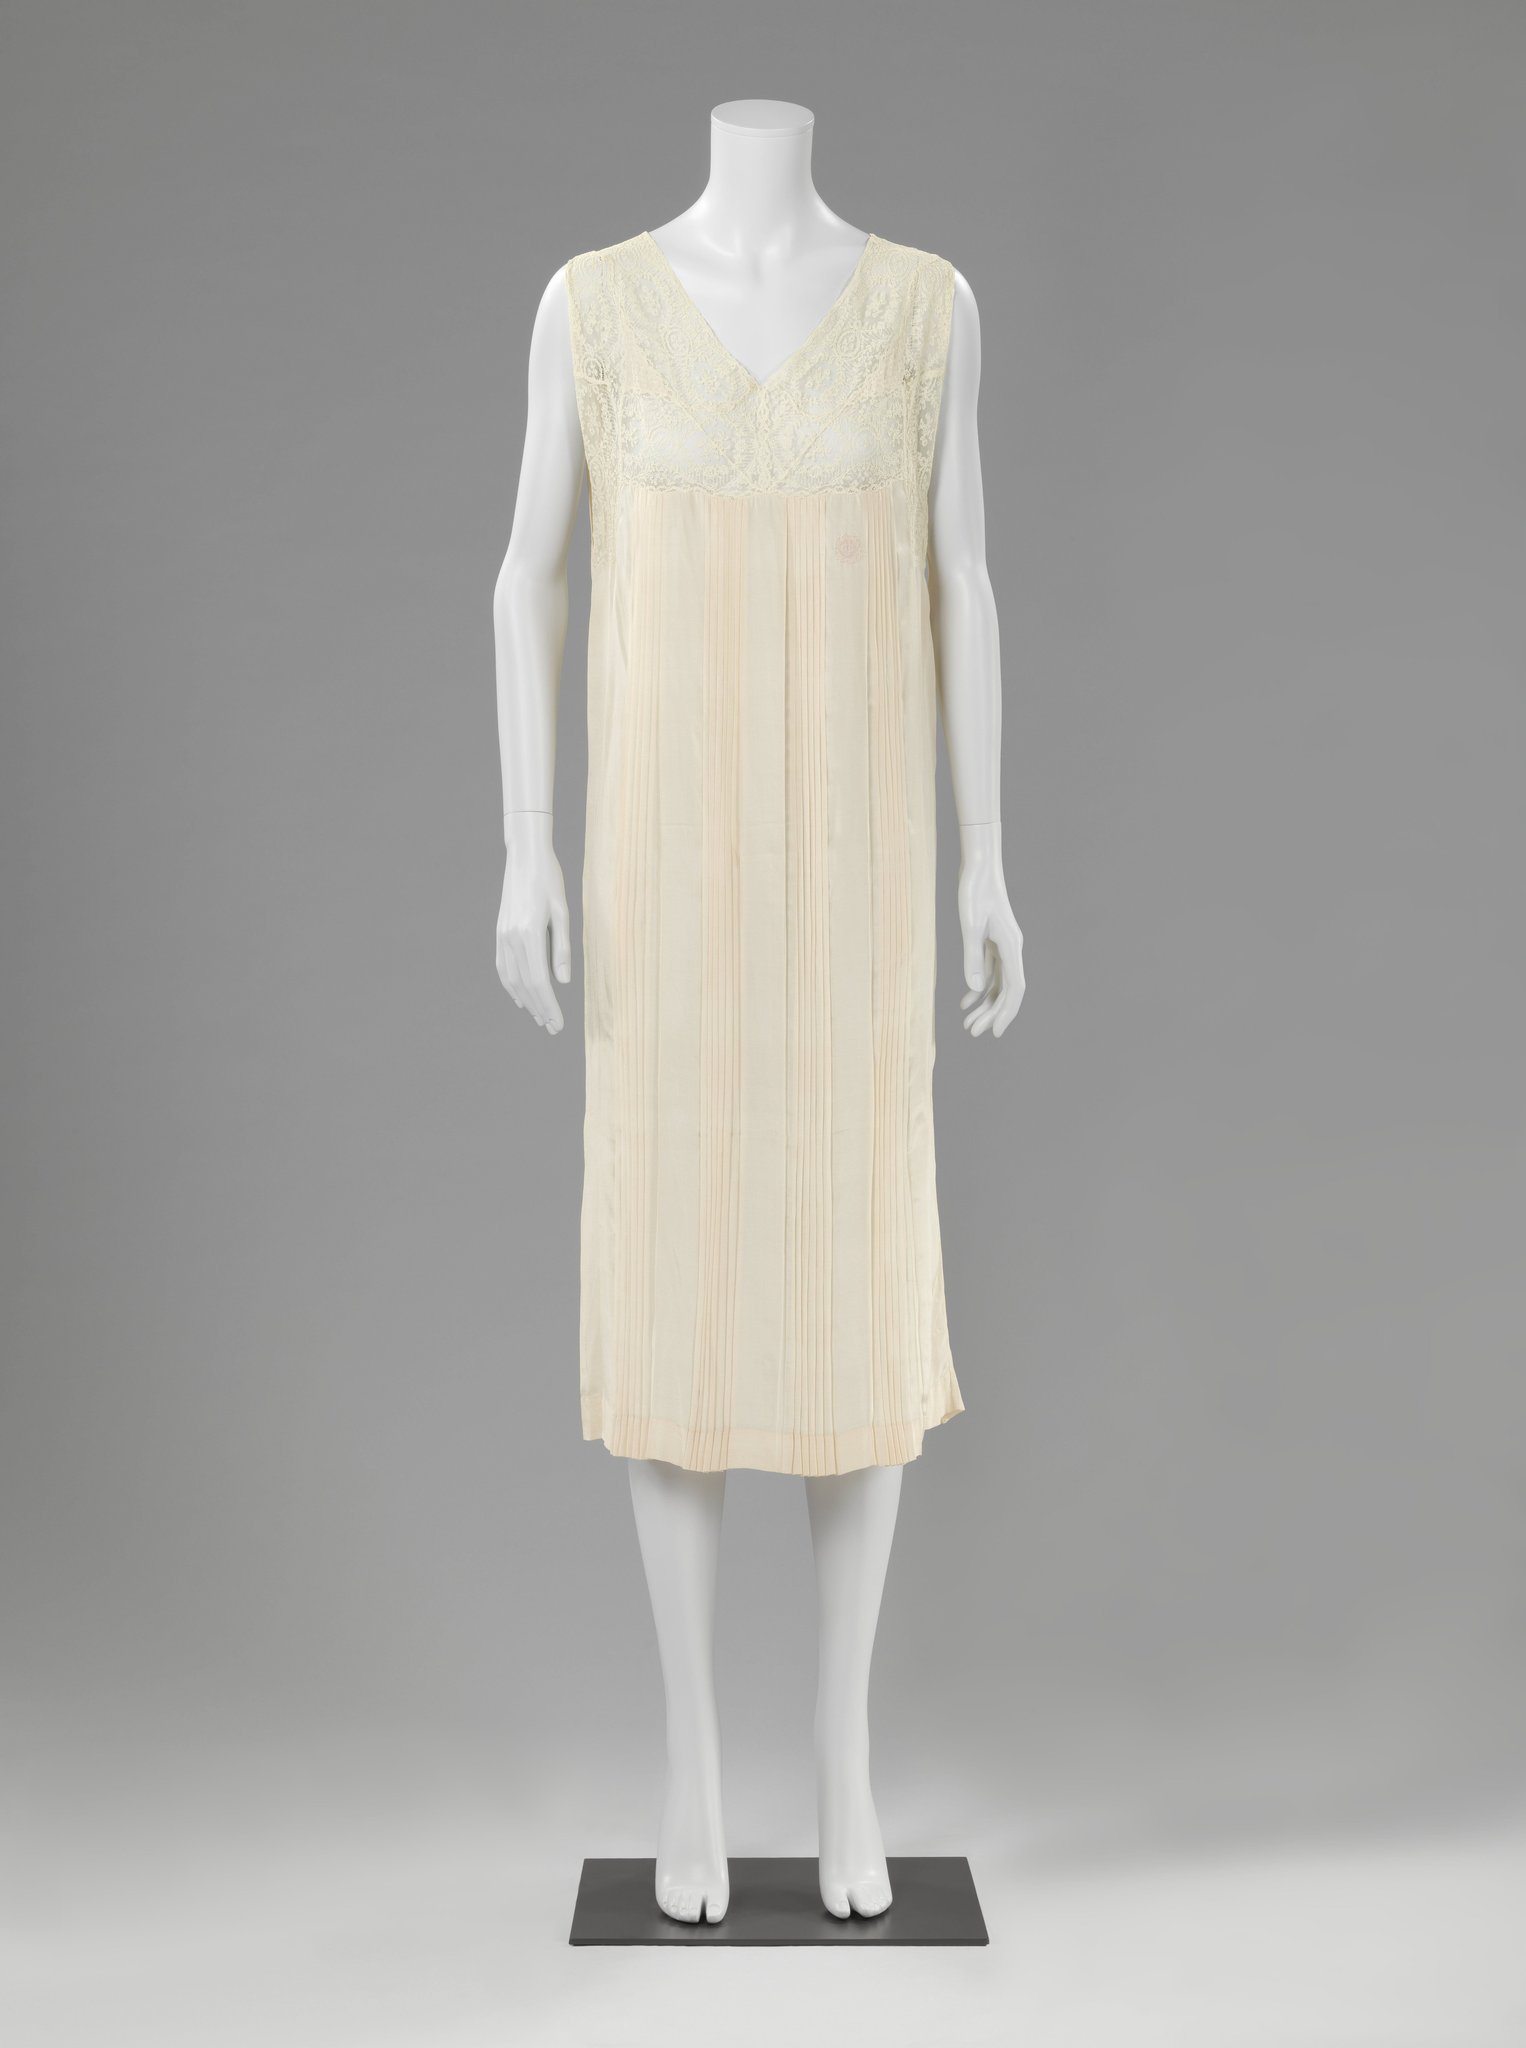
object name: nightgown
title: Nightgown with Lace Yoke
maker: madame watrigant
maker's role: lingère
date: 1925-1930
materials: cotton, silk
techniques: lace, embroidered, pleated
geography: brussels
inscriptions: monogram: ‘AU in krans’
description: The yoke of this nightgown consists of strips of bobbin lace, while the rest is made of pleated silk (crêpe de Chine). Pleating is a technique whereby fabric is pressed into semi-permanent folds. Mrs Brusse sent everything in need of re-pleating to Brussels; according to her, this could not be done well in the Netherlands.